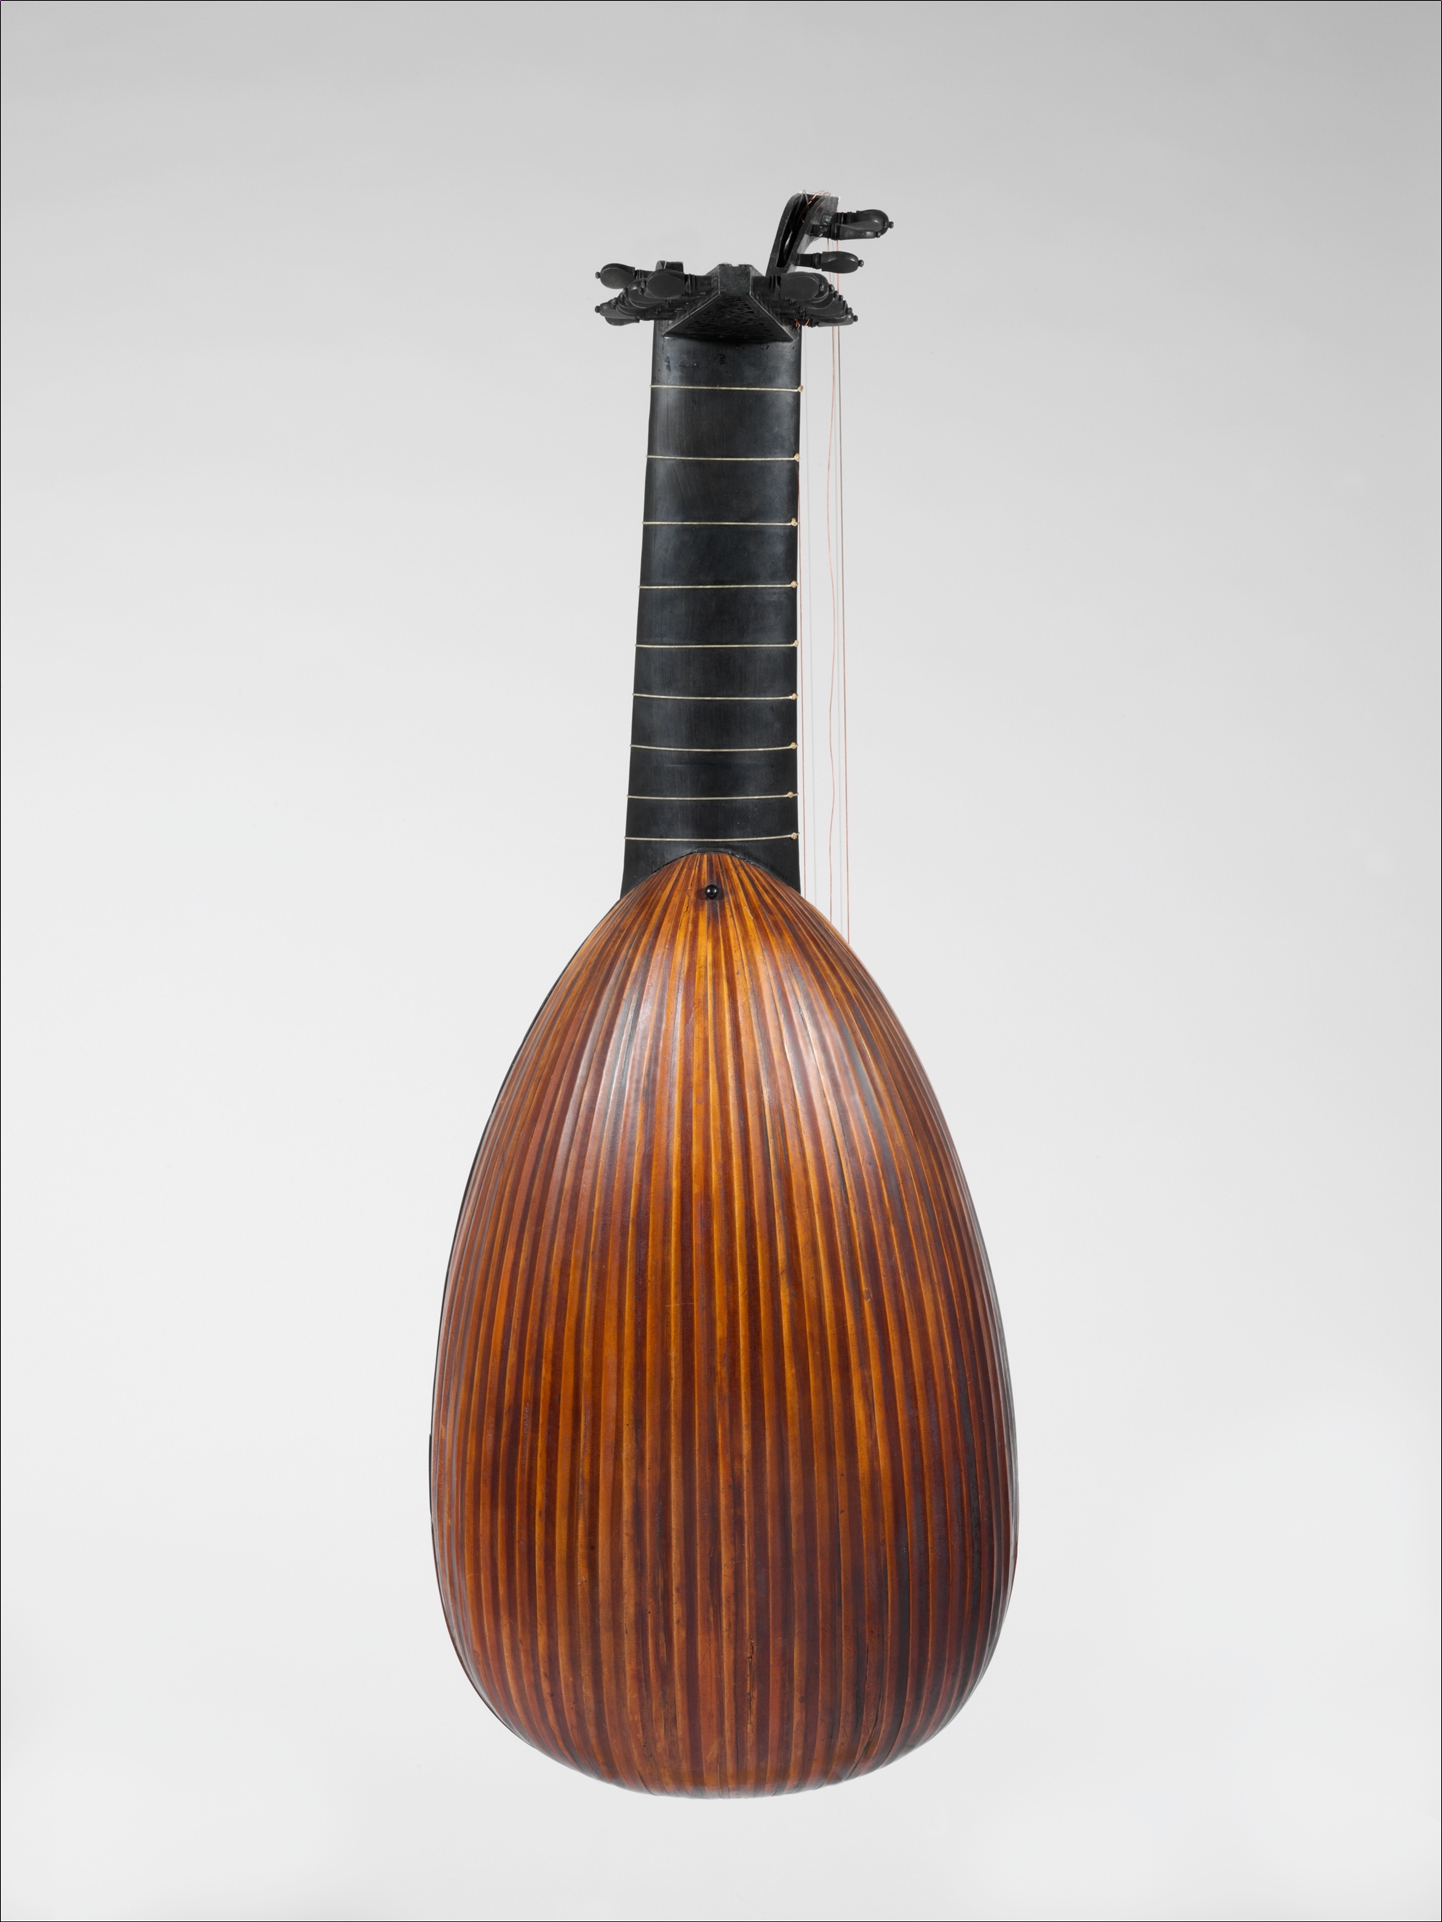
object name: lute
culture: italian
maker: wendelin tieffenbrucker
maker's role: maker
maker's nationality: german, active italy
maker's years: 1570-1610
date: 1567-1600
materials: wood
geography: italy